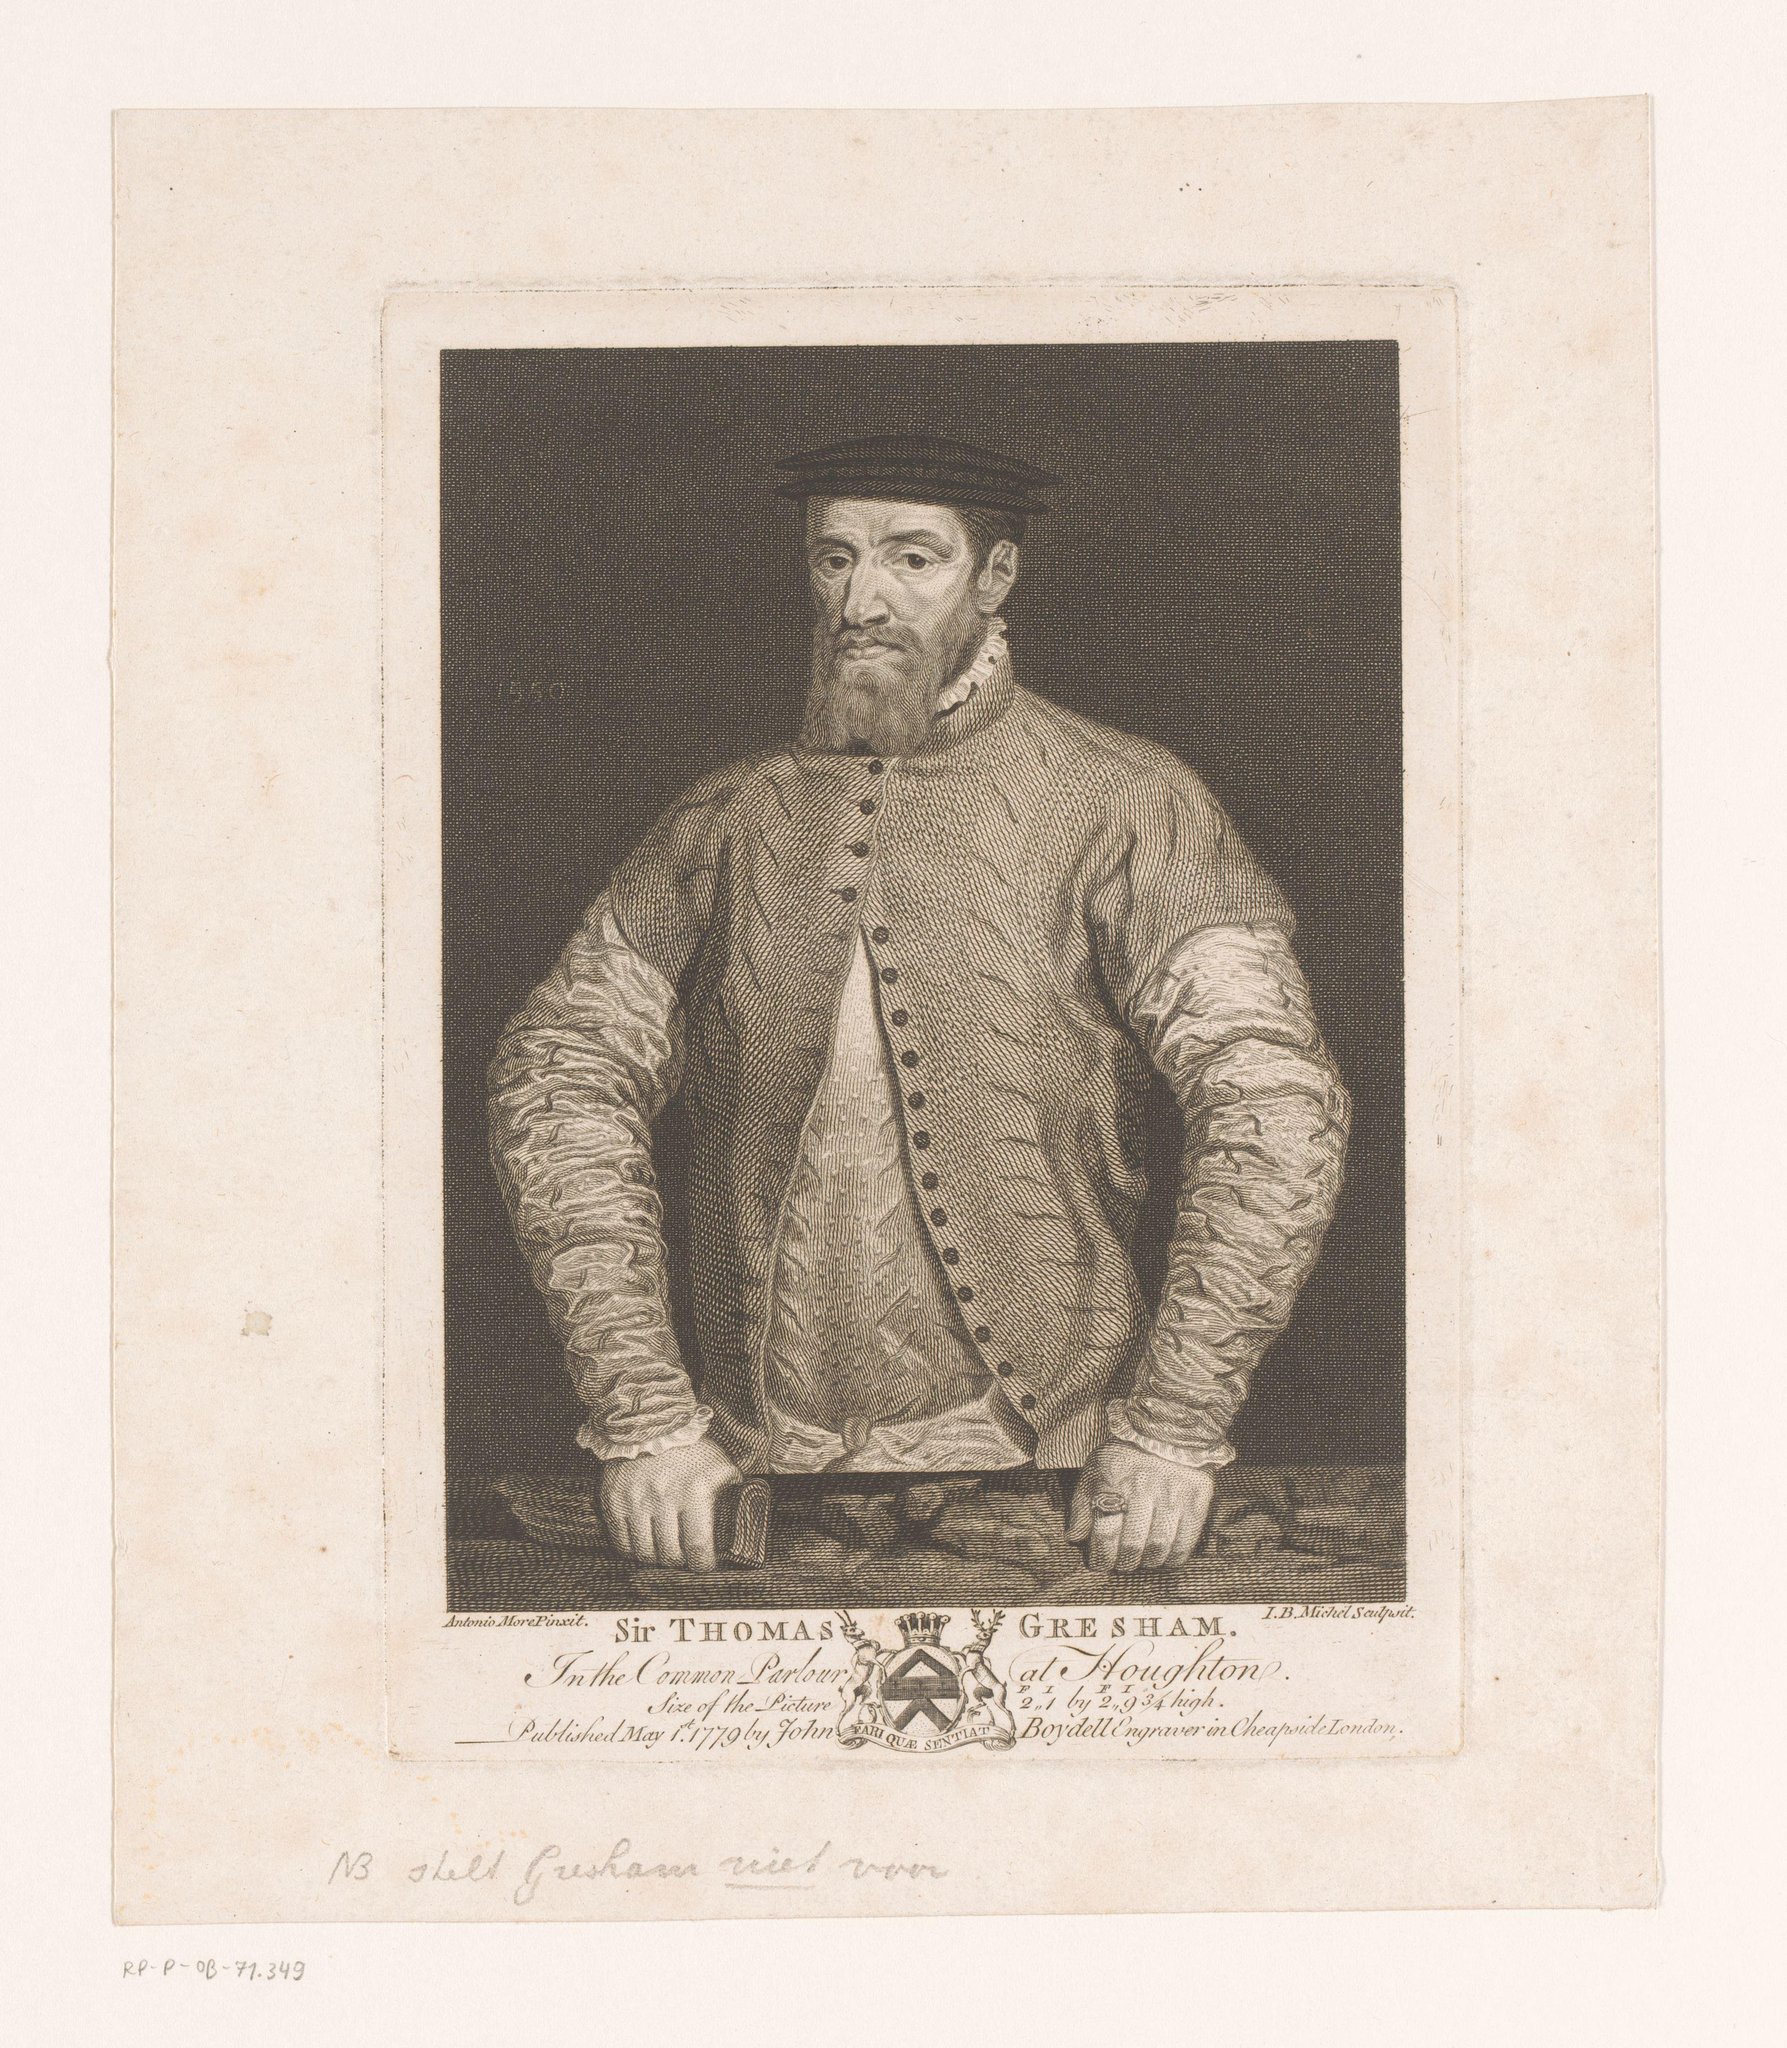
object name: print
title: The Houghton Gallery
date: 1779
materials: paper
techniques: engraving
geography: london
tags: historical persons, armorial bearing, heraldry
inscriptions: collector's mark: Lugt 2228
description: Mogelijk stelt dit portret niet Thomas Gresham voor maar zijn oom, Sir John Gresham (The British Museum).